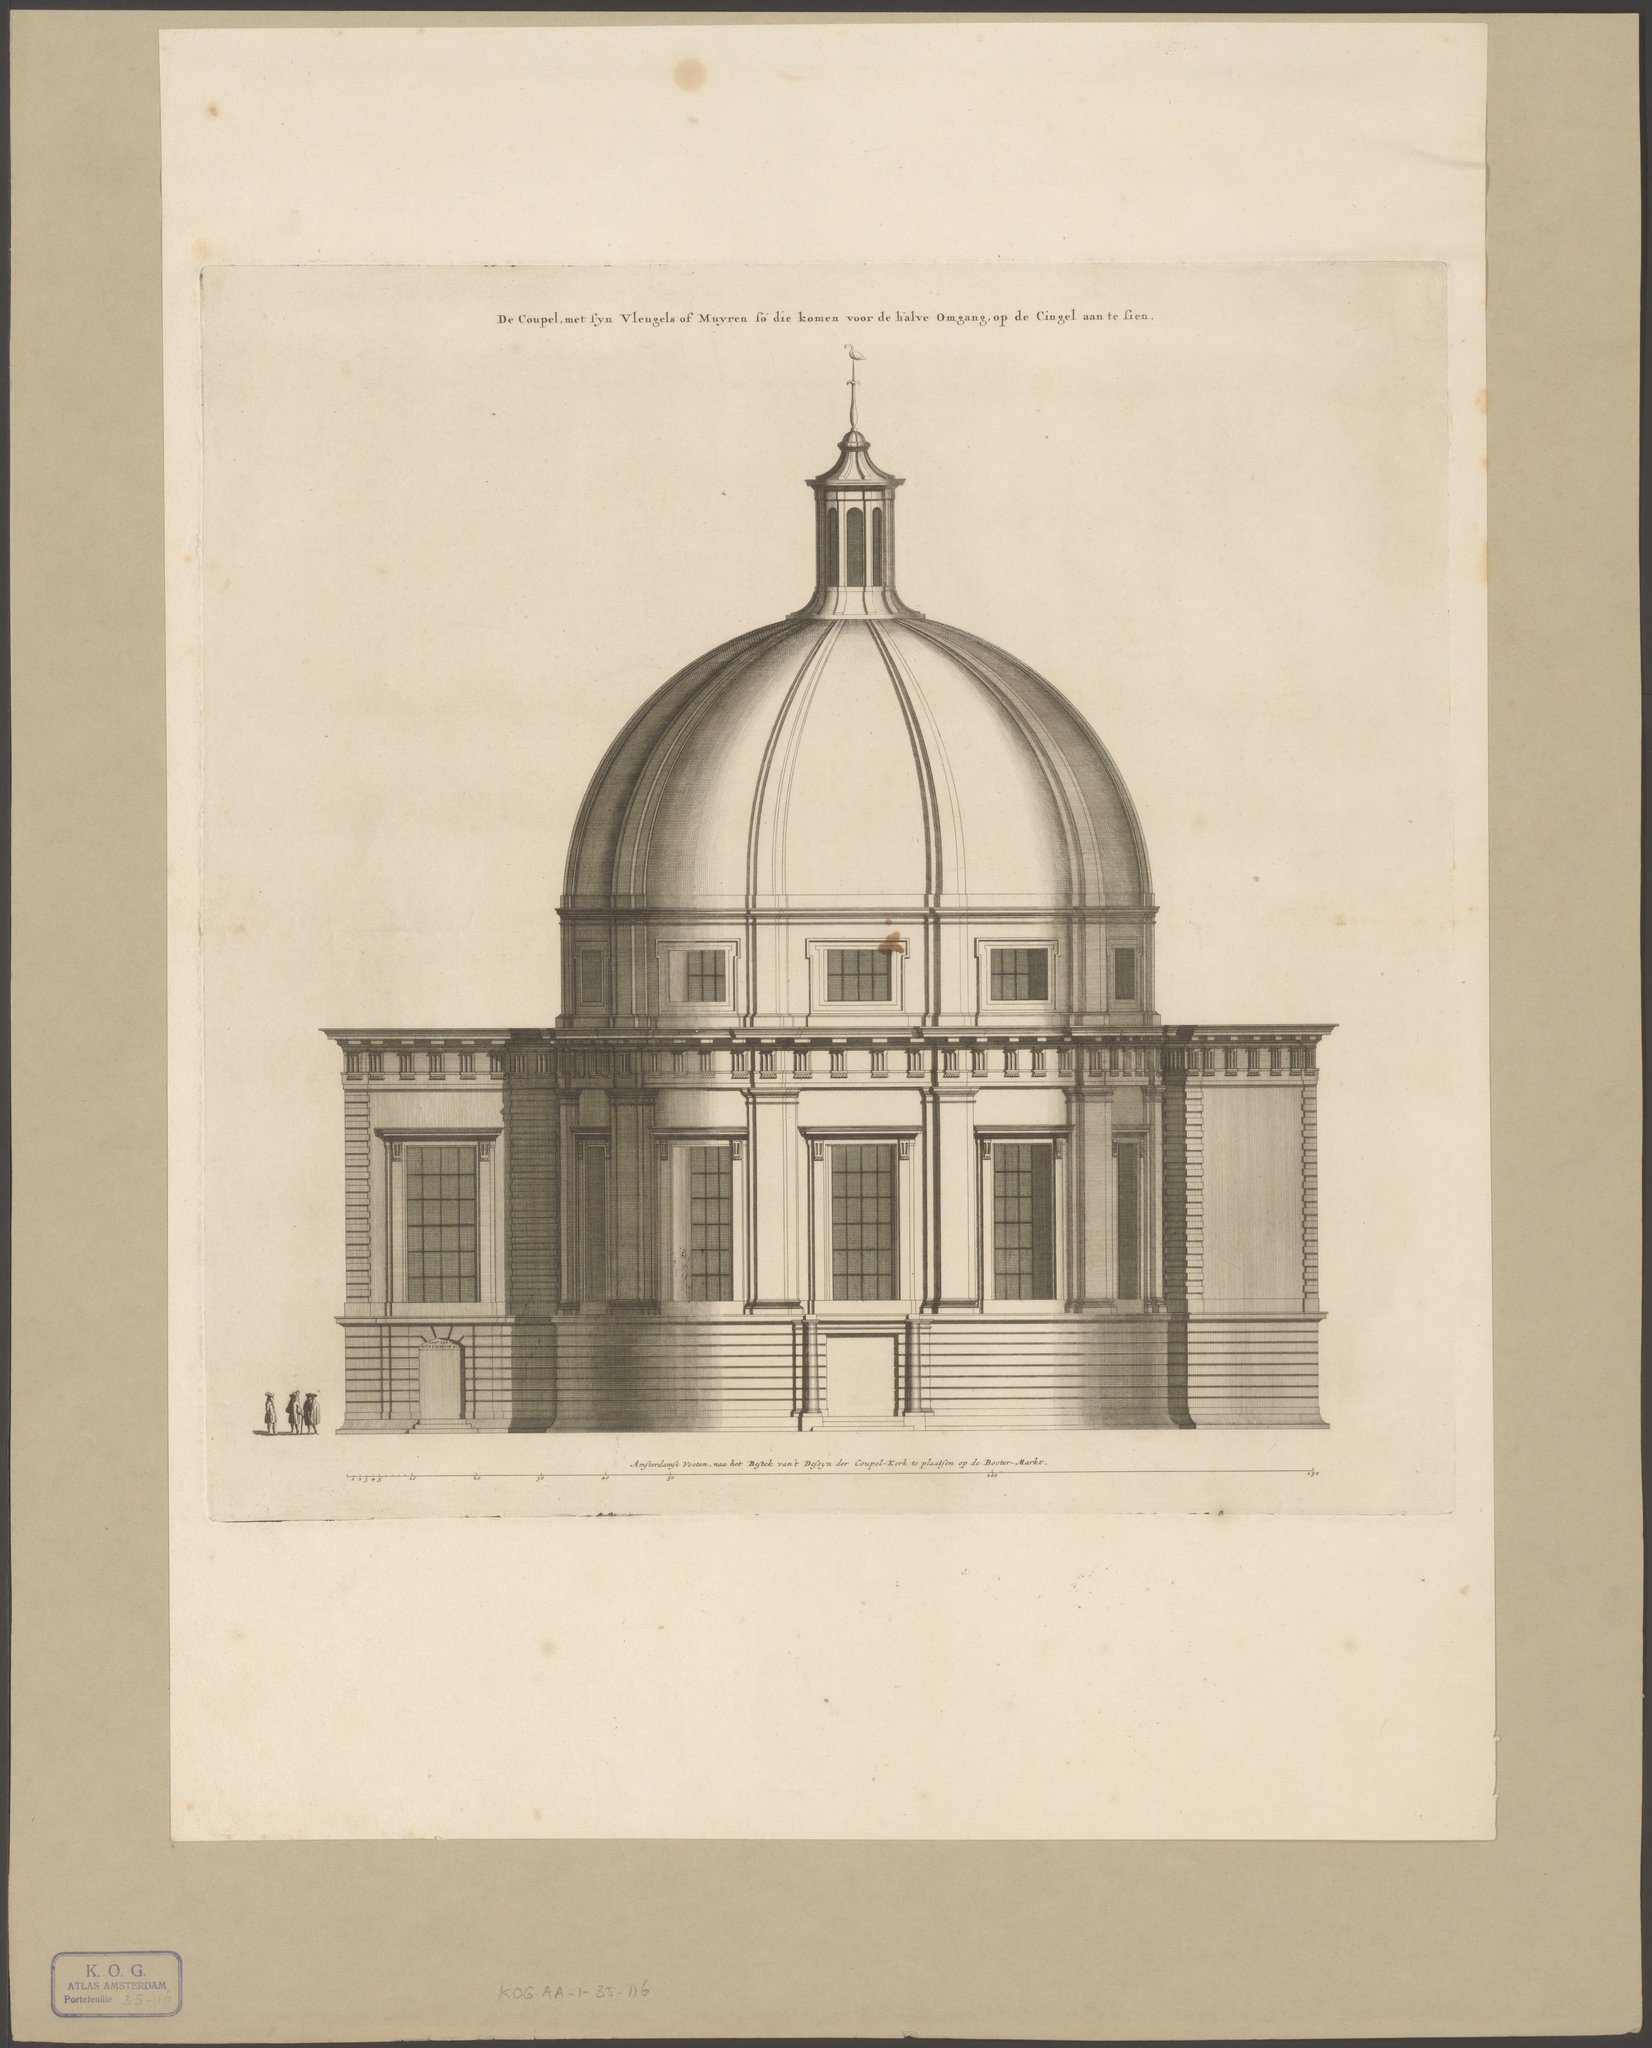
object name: titelblad, titelpagina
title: De Coupel, met syn Vleugels of Muyren, so die komen voor de halve omgang, op den Cingel aan te sien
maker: Anonymous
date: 1668-1750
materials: paper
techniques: engraving, etching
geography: amsterdam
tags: protestant churches and denominations (lutherans), parts of church exterior and annexes: dome, façade ~ architectural design or model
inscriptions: collector's mark: ‘35-116’ Lugt 1641b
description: Met het onderschrift: 'Amsterdamsche voeten naar het bestek van 't dessyn der Coupelkerk, te plaatsen op de Botermarkt' en een maatstok van 150 Amsterdamse voeten. Onderwerpsrubriek binnen de Atlas Amsterdam: Ev. Lutherse Gemeente: Nieuwe of Ronde Kerk.